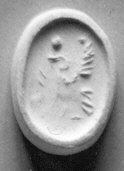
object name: stamp seal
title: Stamp seal (scarab) with animal or monster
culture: phoenician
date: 700-801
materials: stone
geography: cyprus